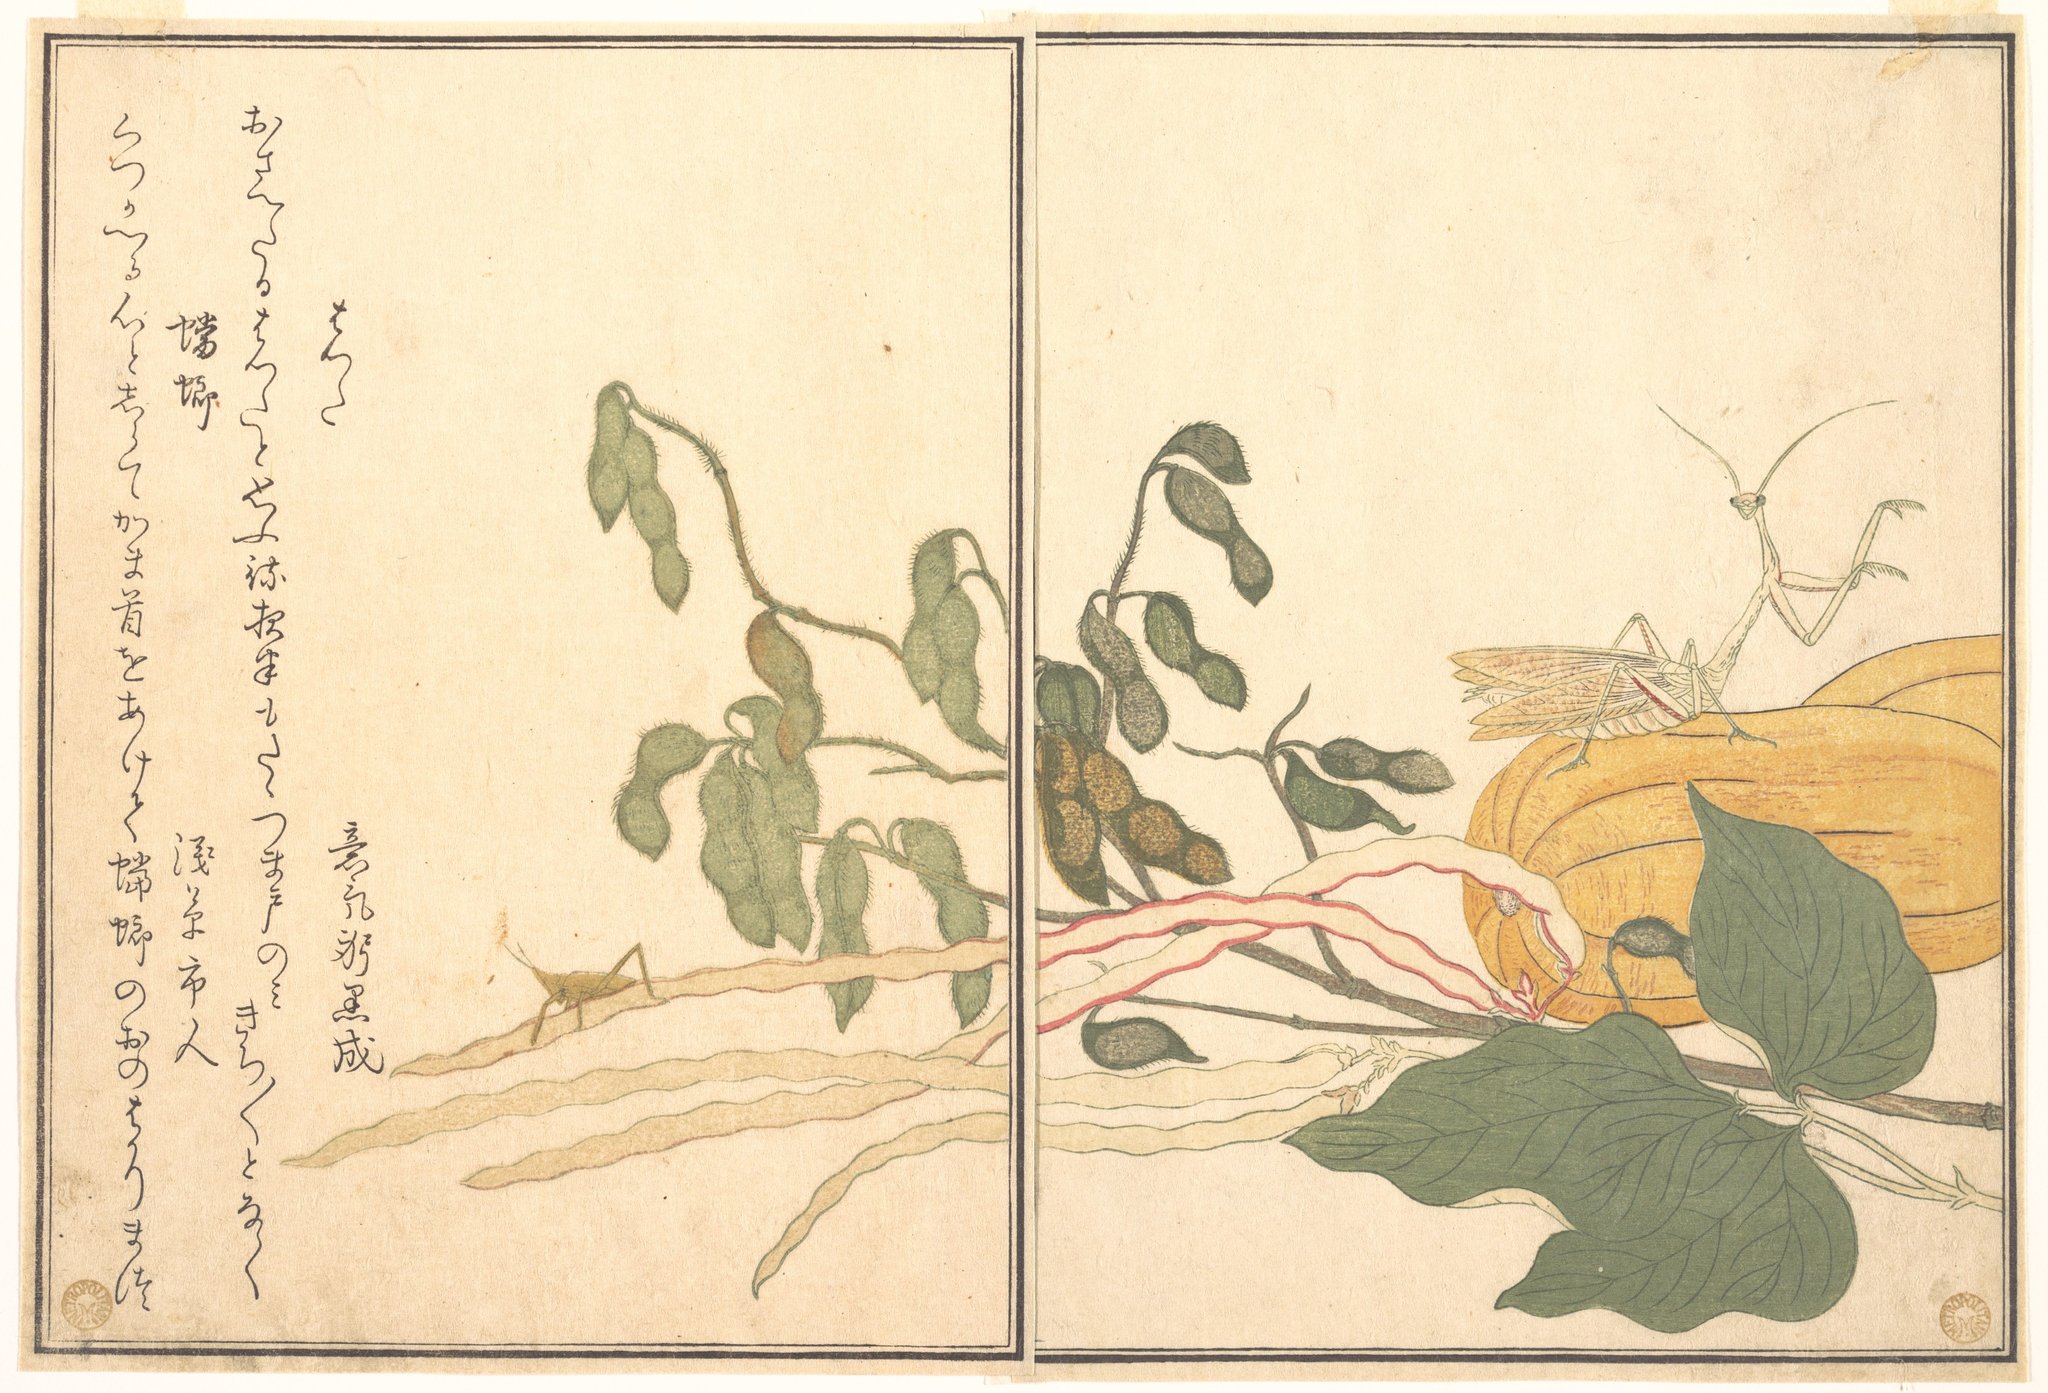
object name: woodblock print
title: Cone-headed Grasshopper or Locust, (batta); Praying Mantis (Tōrō or Kamakiri), from the Picture Book of Crawling Creatures (Ehon mushi erami)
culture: japanese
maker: kitagawa utamaro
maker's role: artist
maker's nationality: japanese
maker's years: 1754-1806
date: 1788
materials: ink, paper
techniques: woodblock print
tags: fruit,insects,leaves